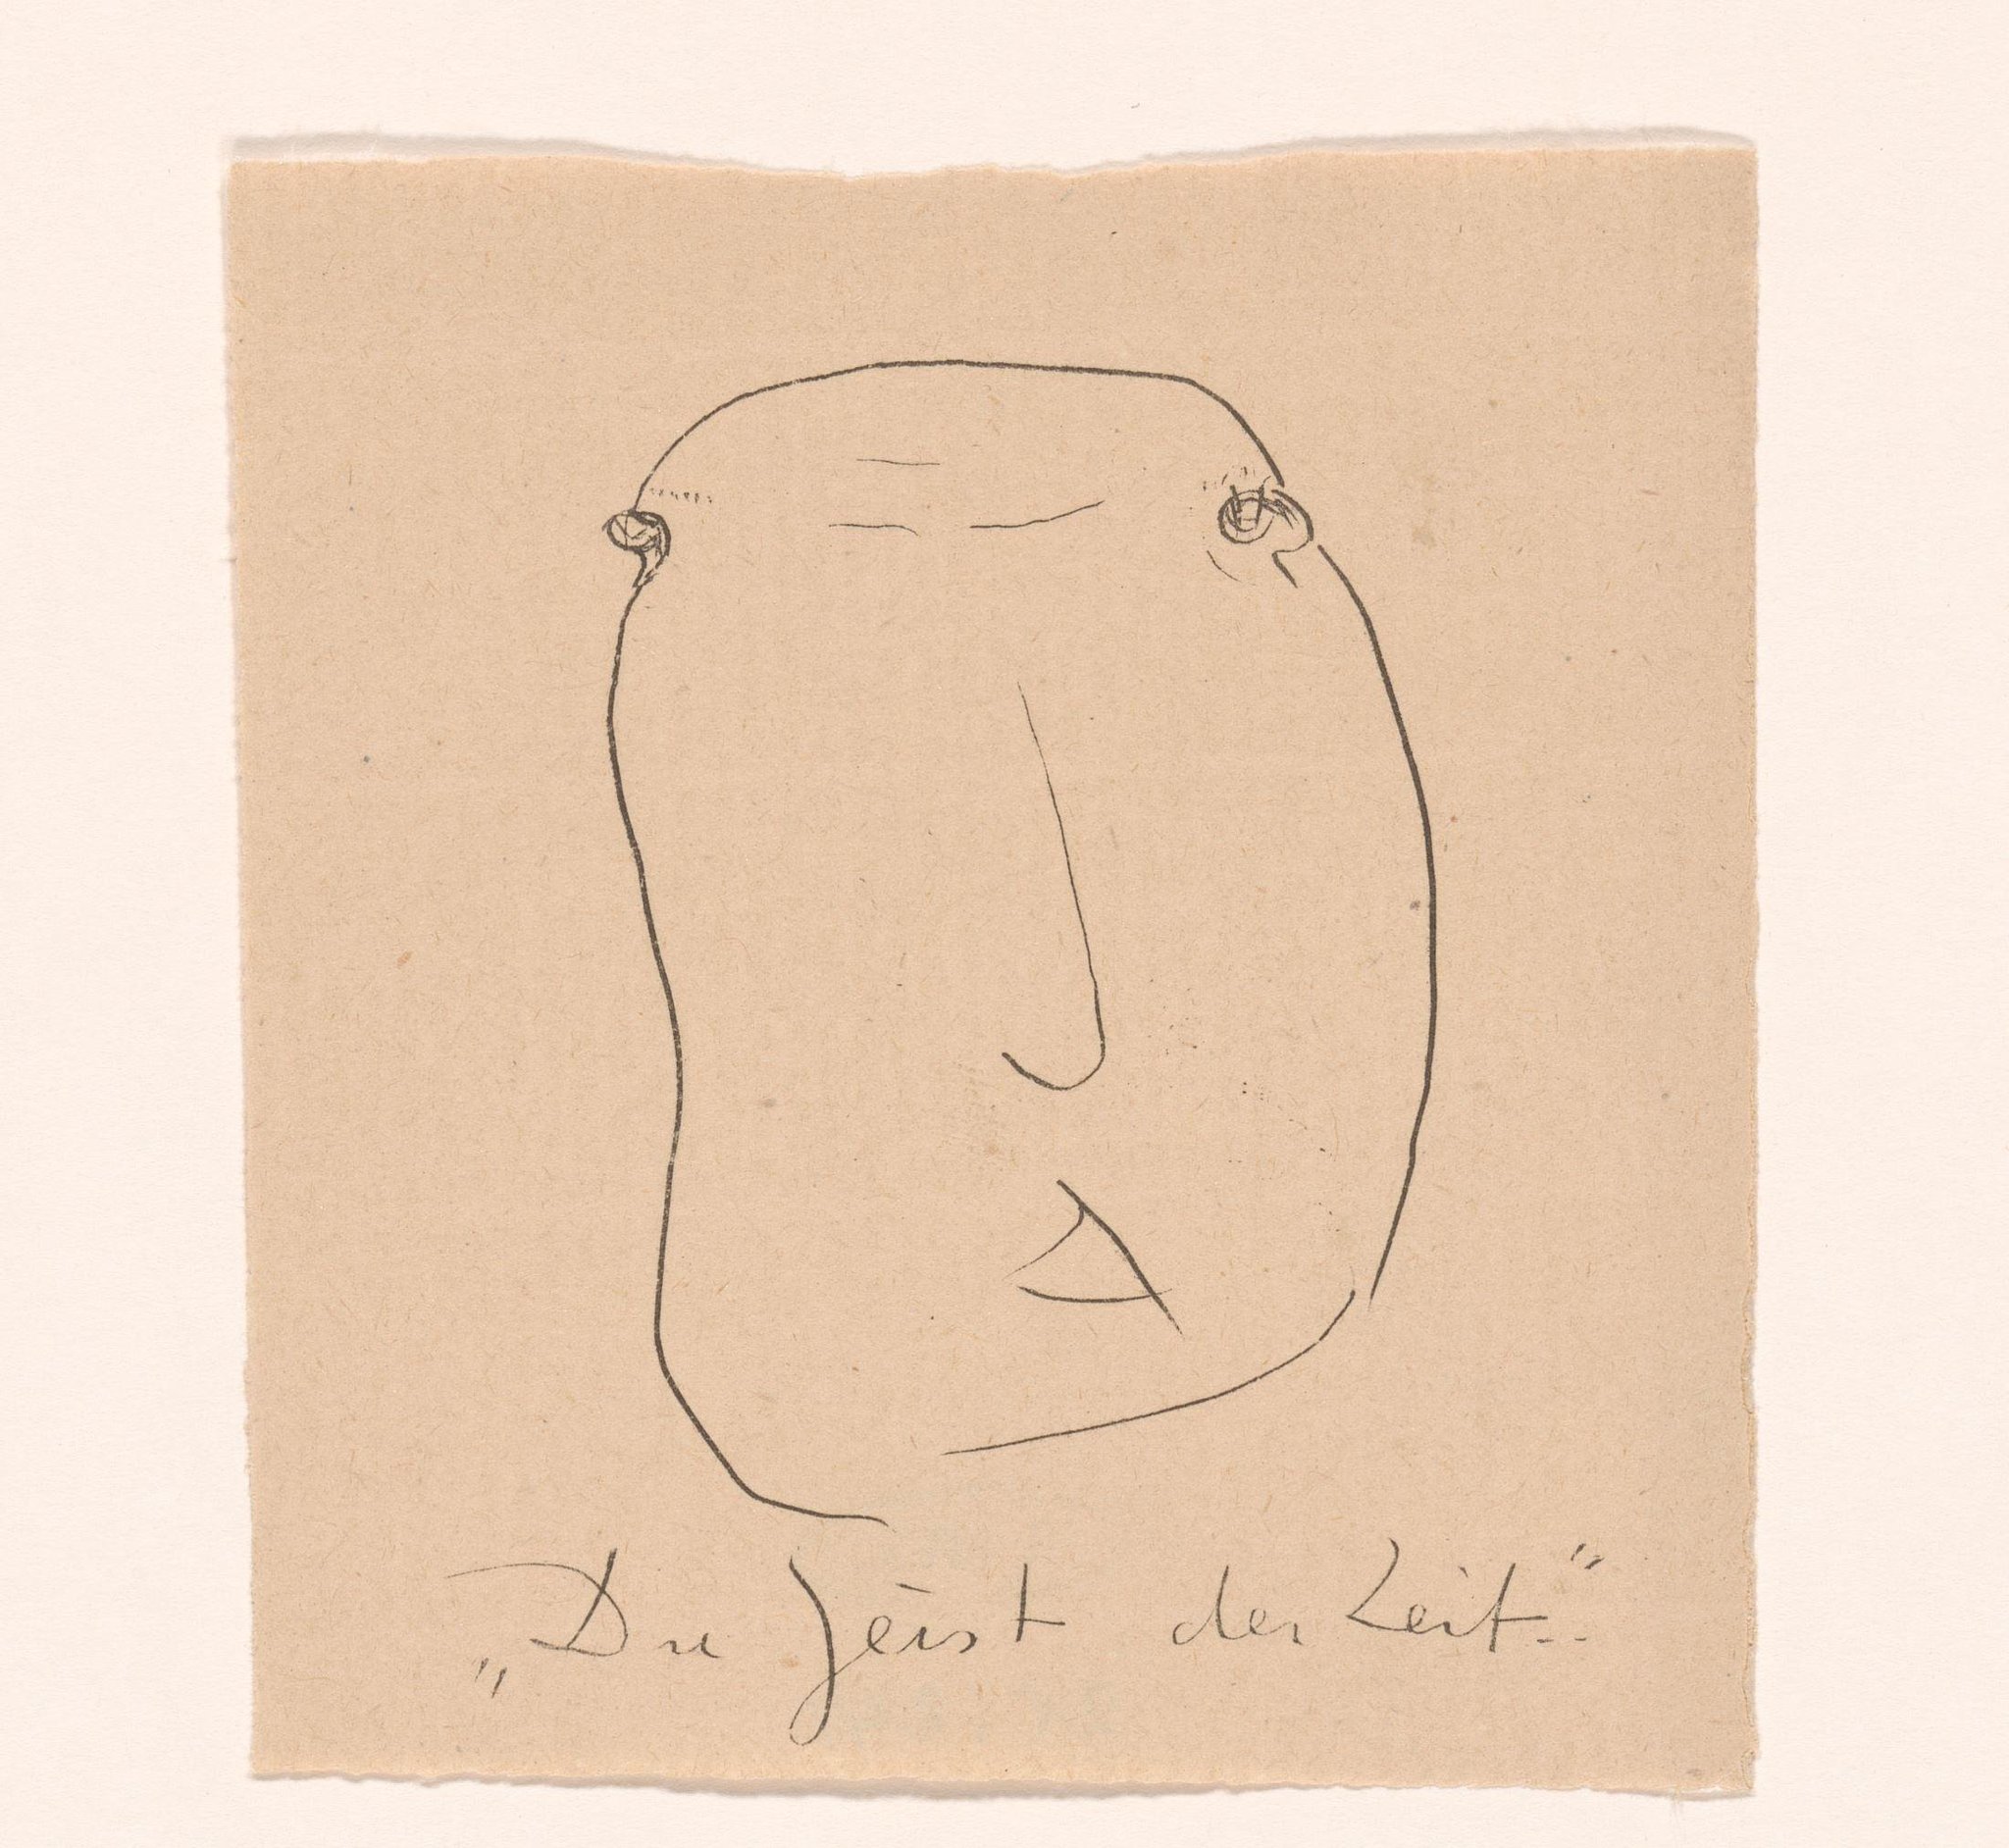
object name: print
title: Idealisten II en verdere Kanttekeningen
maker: erich wichmann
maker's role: print maker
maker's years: 1890-1929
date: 1923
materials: paper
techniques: lithograph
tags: caricatures (human types)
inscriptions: collector's mark: Lugt 2228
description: Karikaturaal gezicht met de ogen aan de zijkanten van het hoofd.